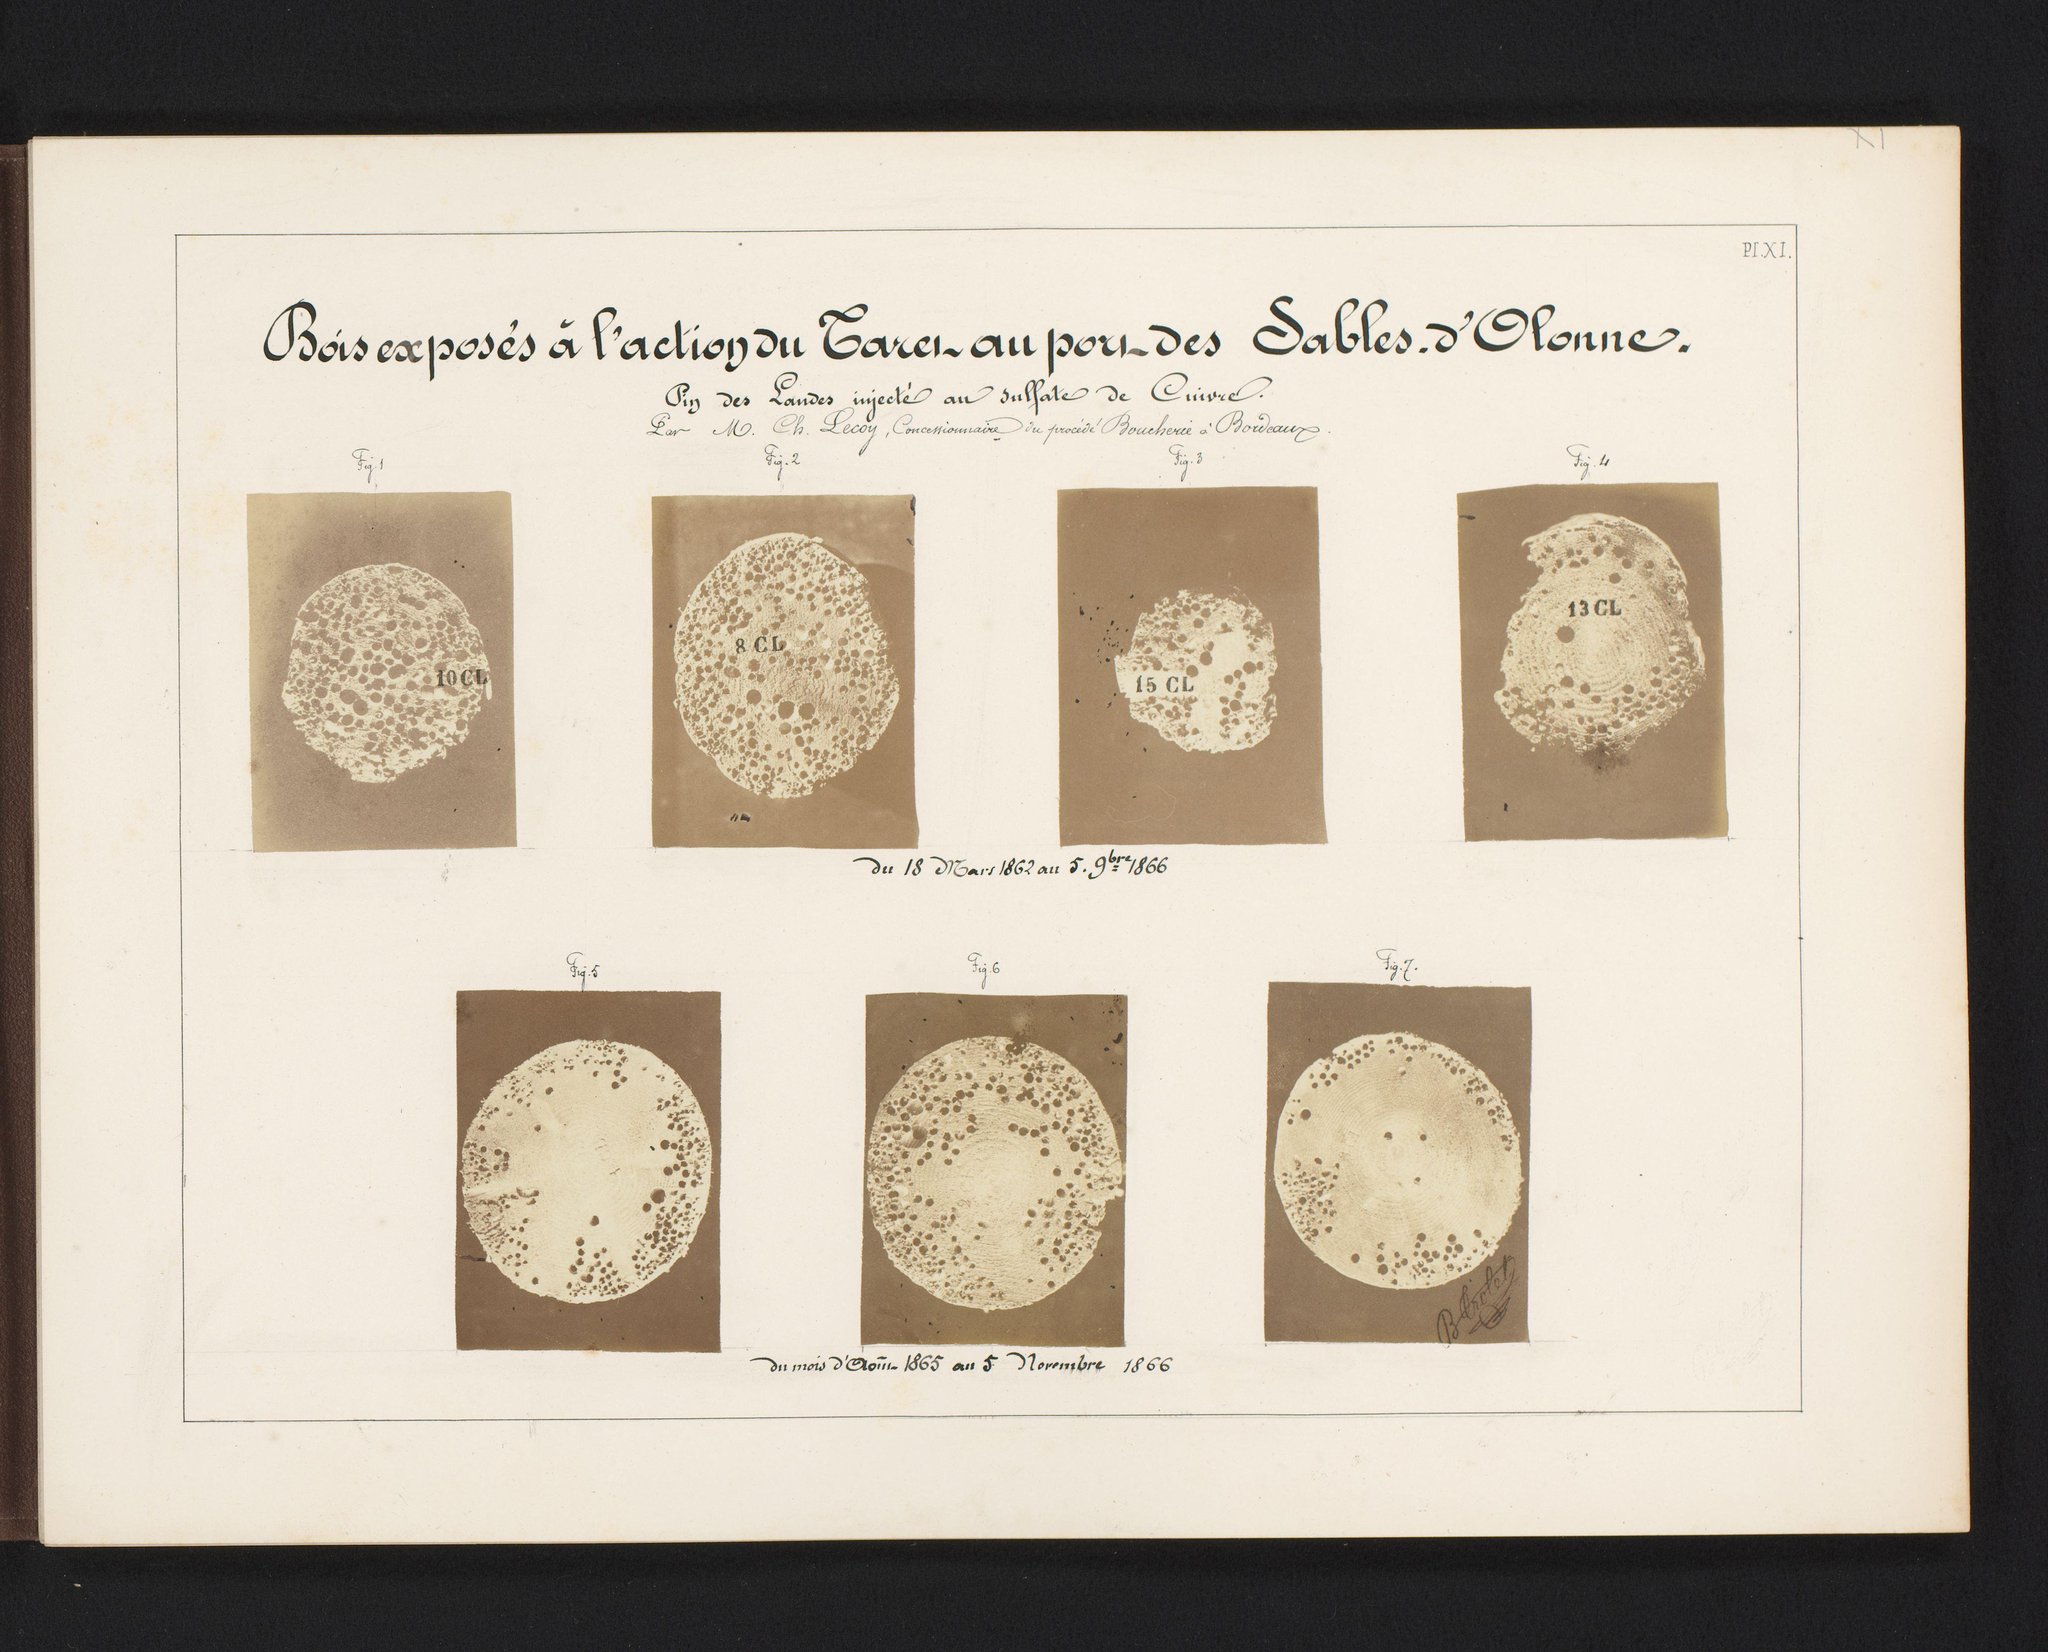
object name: photograph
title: Bois exposés à l'action du Taret au port des Sables-d'Olonne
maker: b. crolet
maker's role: fotograaf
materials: cardboard, photographic support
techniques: albumen print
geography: france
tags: worms, wood, timber ~ building material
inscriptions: signature: ‘B. Crolet’, annotation: ‘Pin des Landes injecté au sulfate de Cuivre/ (...) 5 Novembre 1866’, number: ‘Pl. XI.’